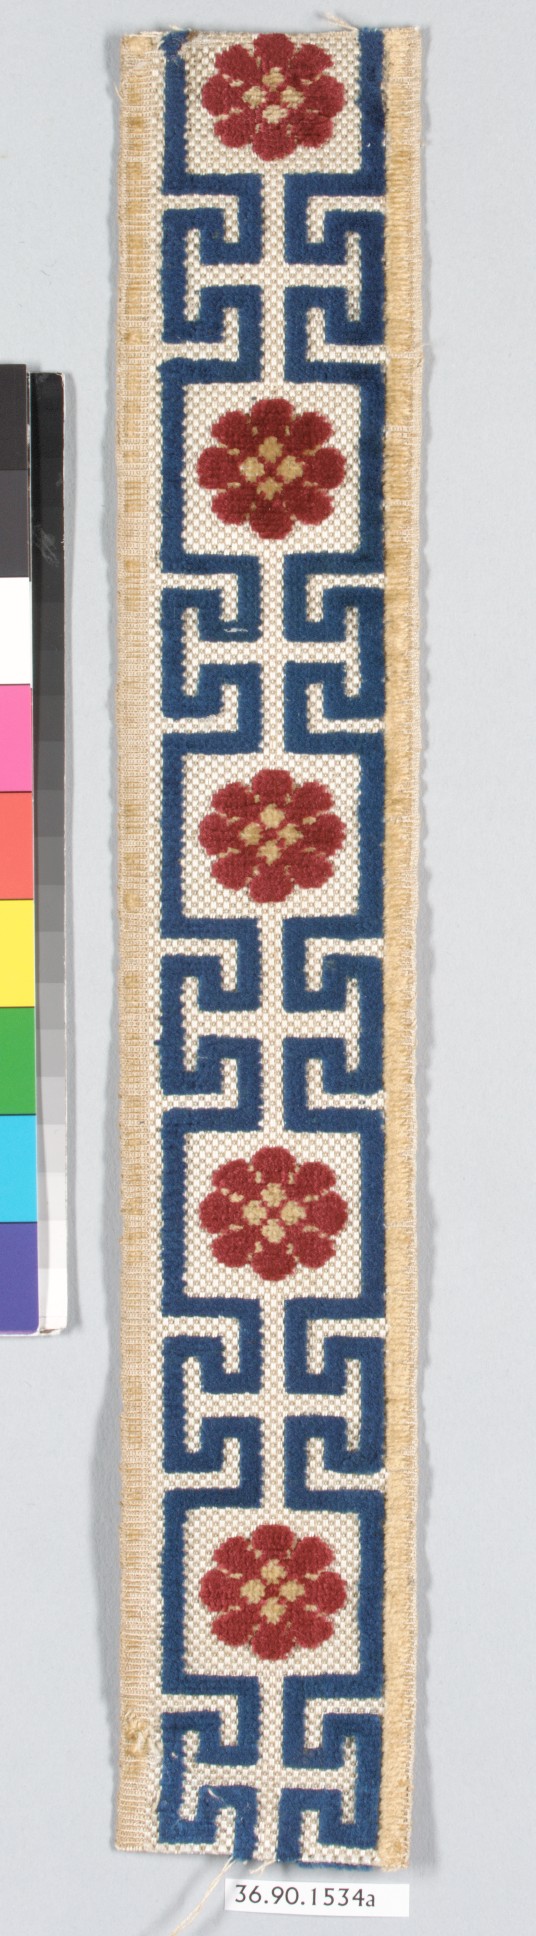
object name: galloon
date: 1701-1900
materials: silk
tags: flowers